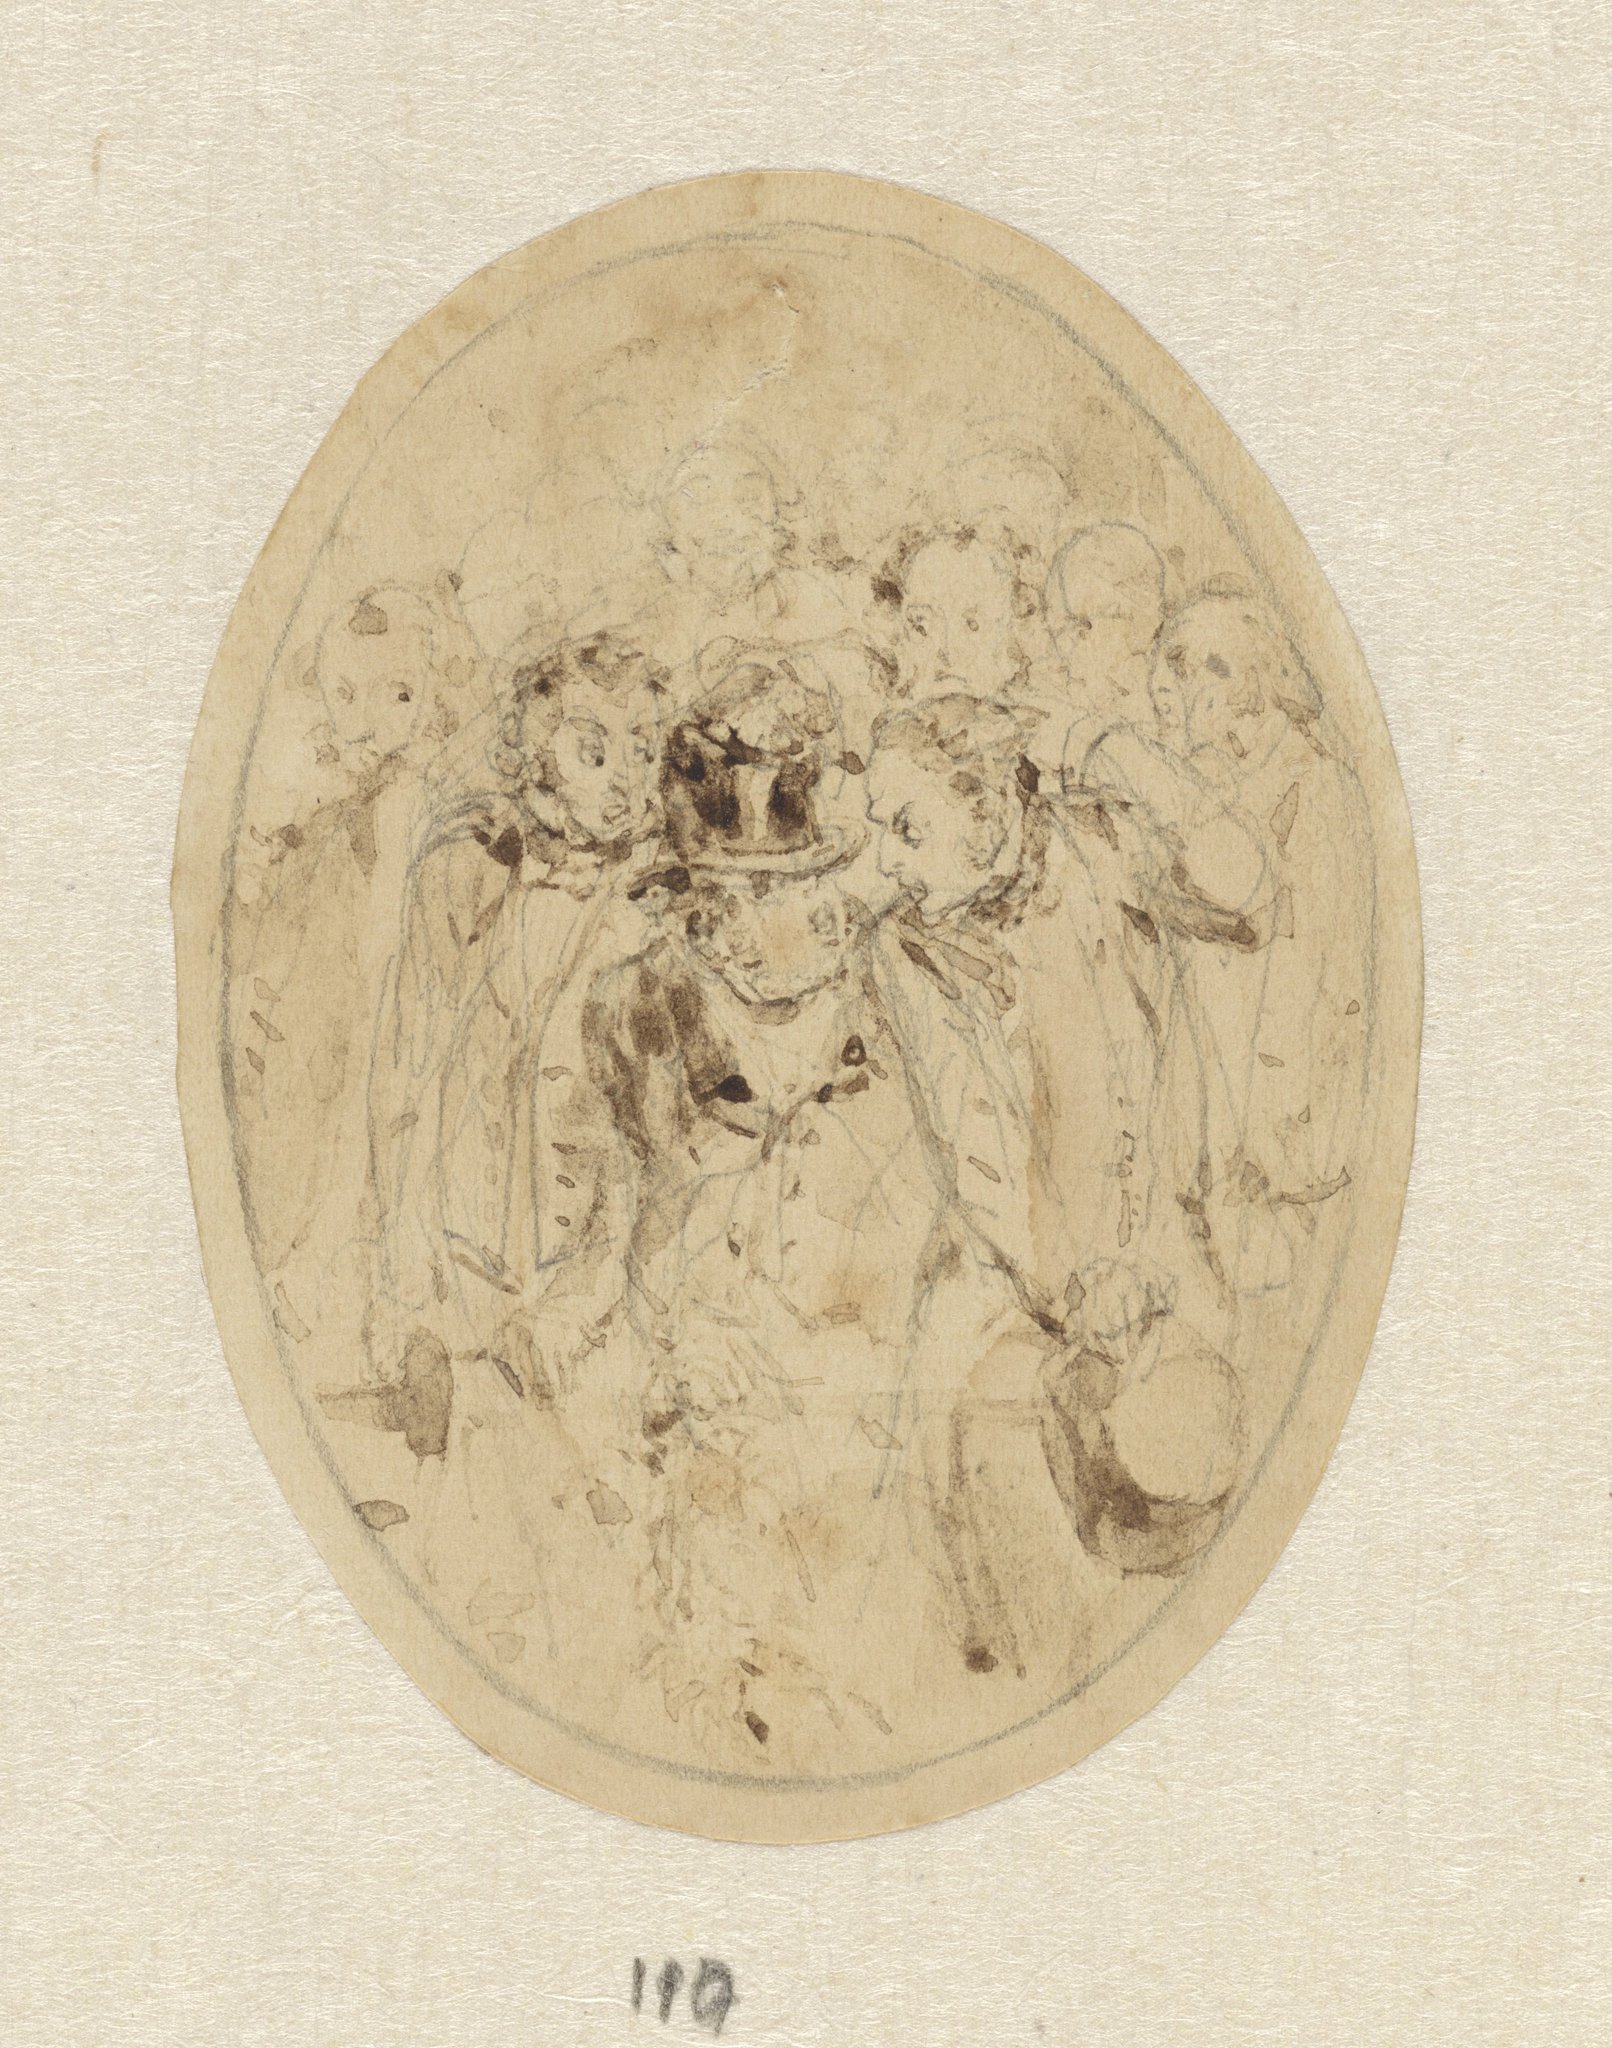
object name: drawing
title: Woordenwisseling tussen heren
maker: herman frederik carel ten kate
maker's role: draughtsman, painter, print maker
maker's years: 1822-1891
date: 1832-1891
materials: paper, pencil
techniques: brush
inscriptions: inscription: ‘4’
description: Boekillustratie voor roman uitgegeven door A.C. Kruseman te Haarlem, no.4 (?)